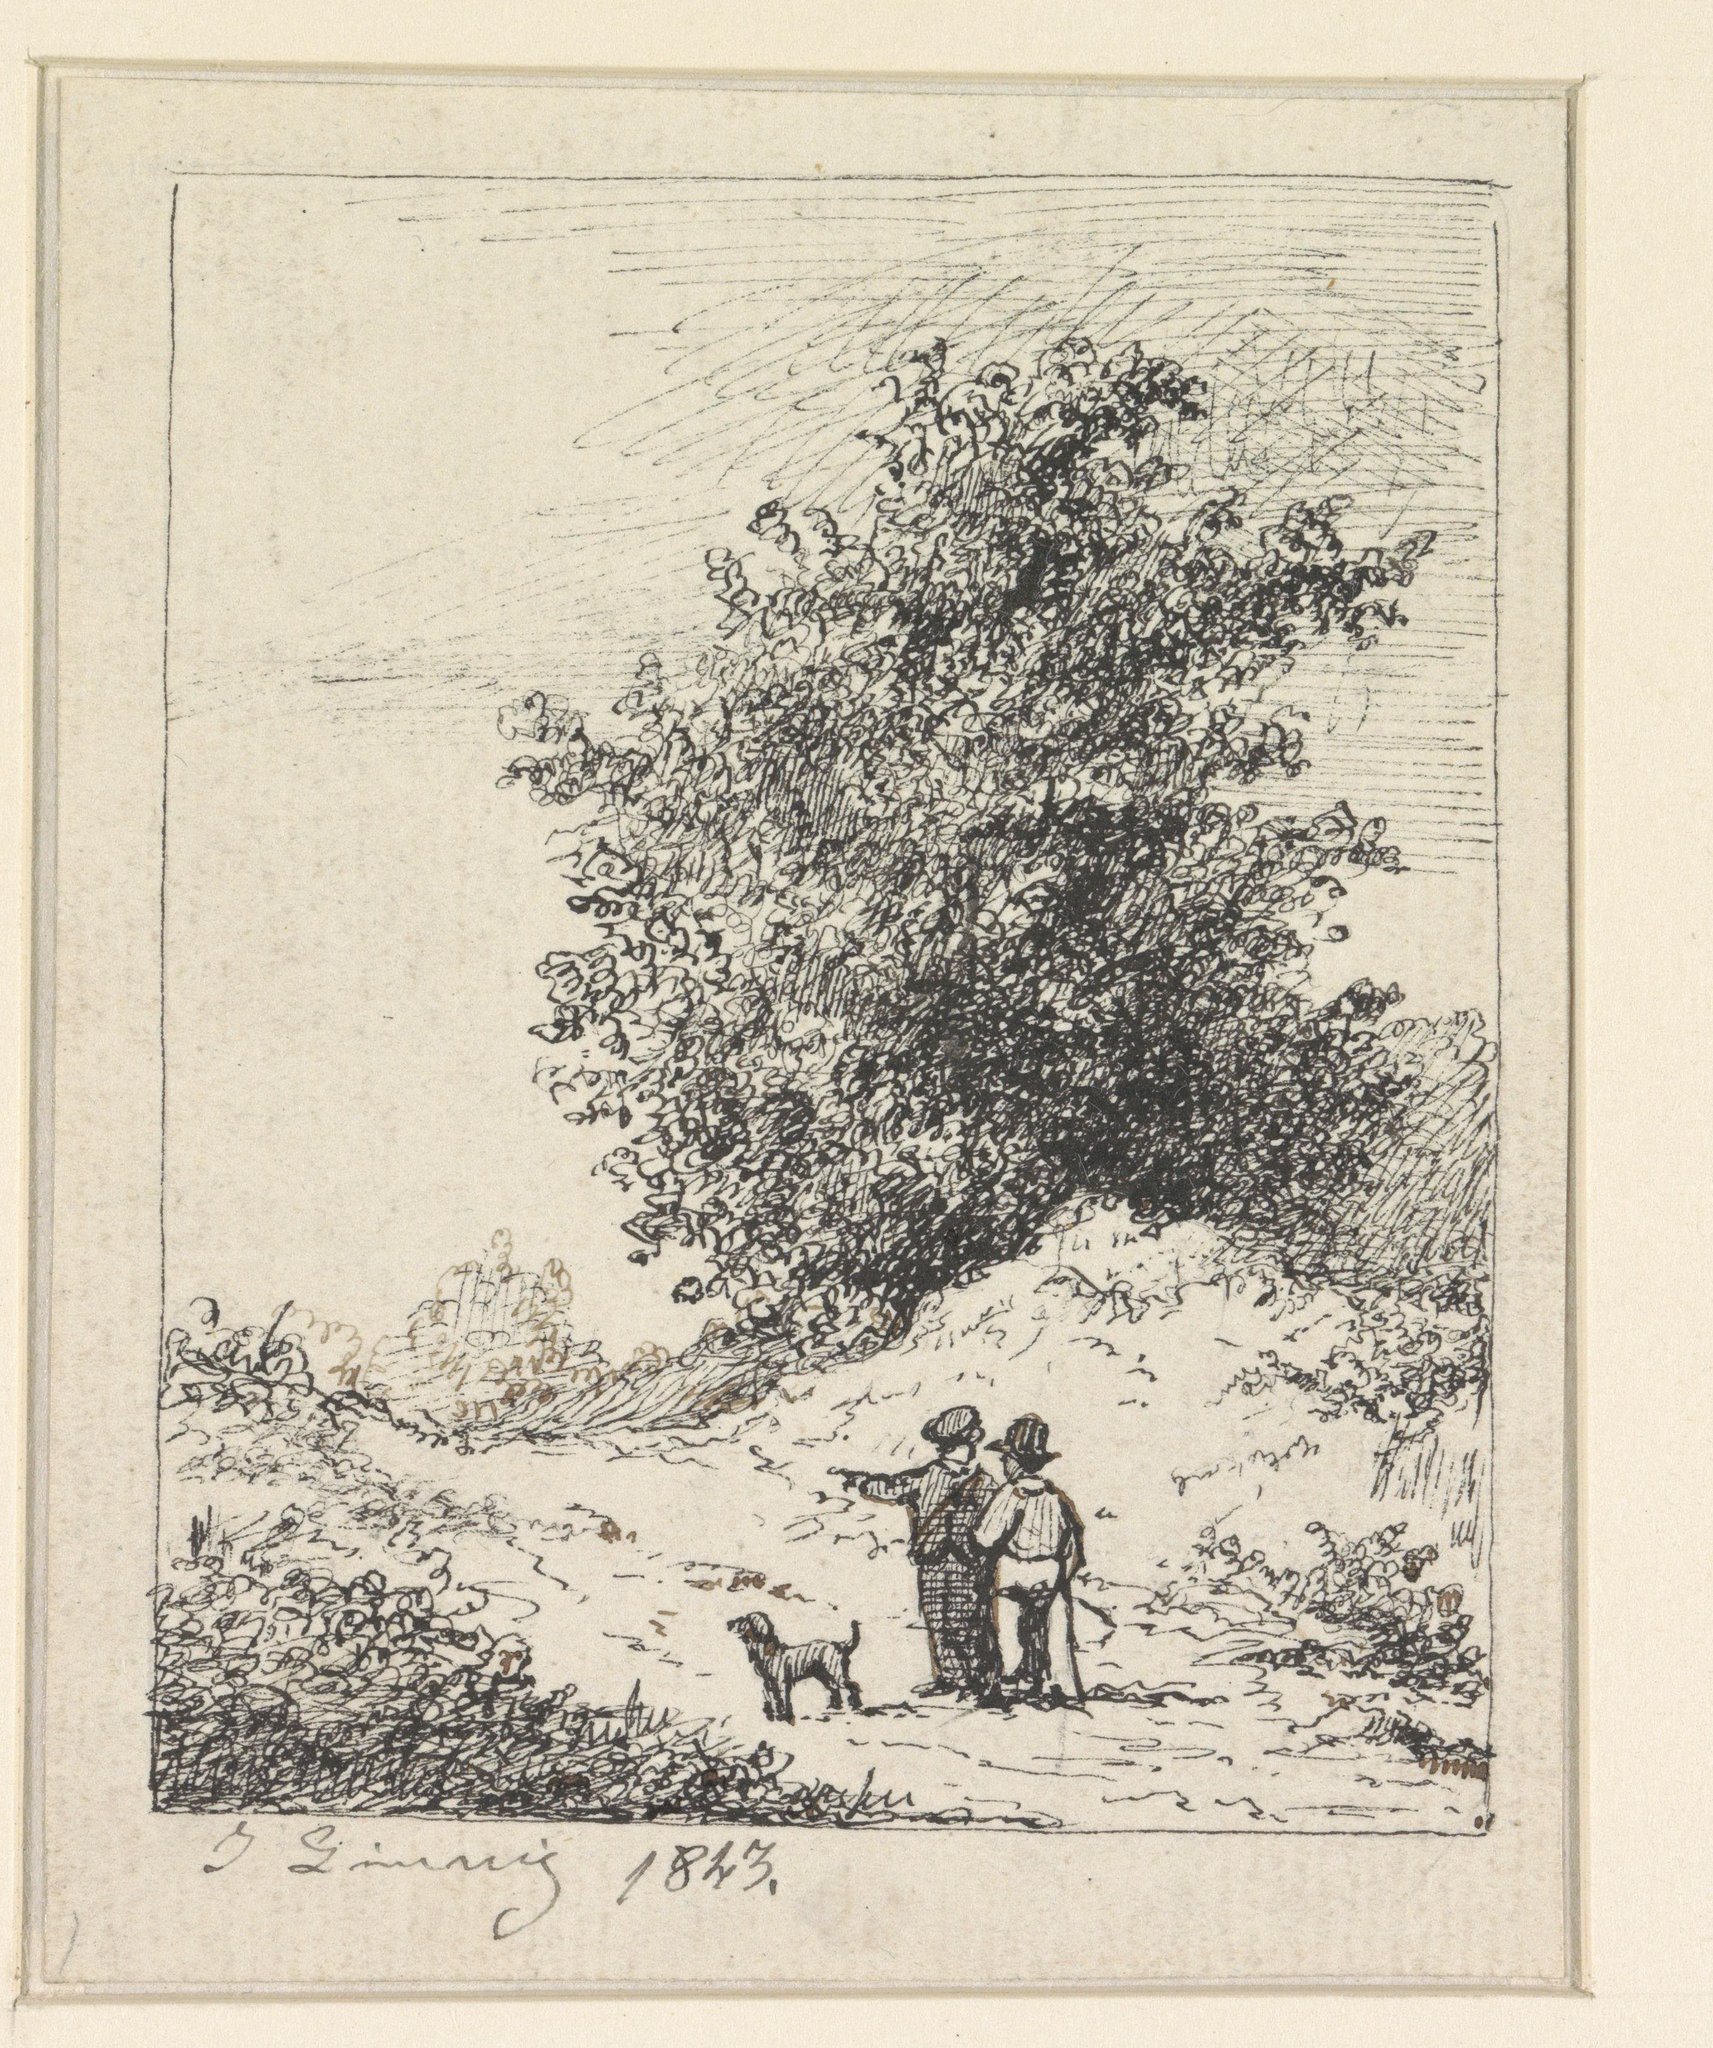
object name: design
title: Landschap bij Tienen met twee mannen en een hond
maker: jean théodore joseph linnig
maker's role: draughtsman, print maker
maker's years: 1815-1891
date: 1843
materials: ink, paper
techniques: pen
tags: landscapes in the temperate zone, belgium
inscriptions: date: ‘1843’, inscription: ‘A Tirlemont’